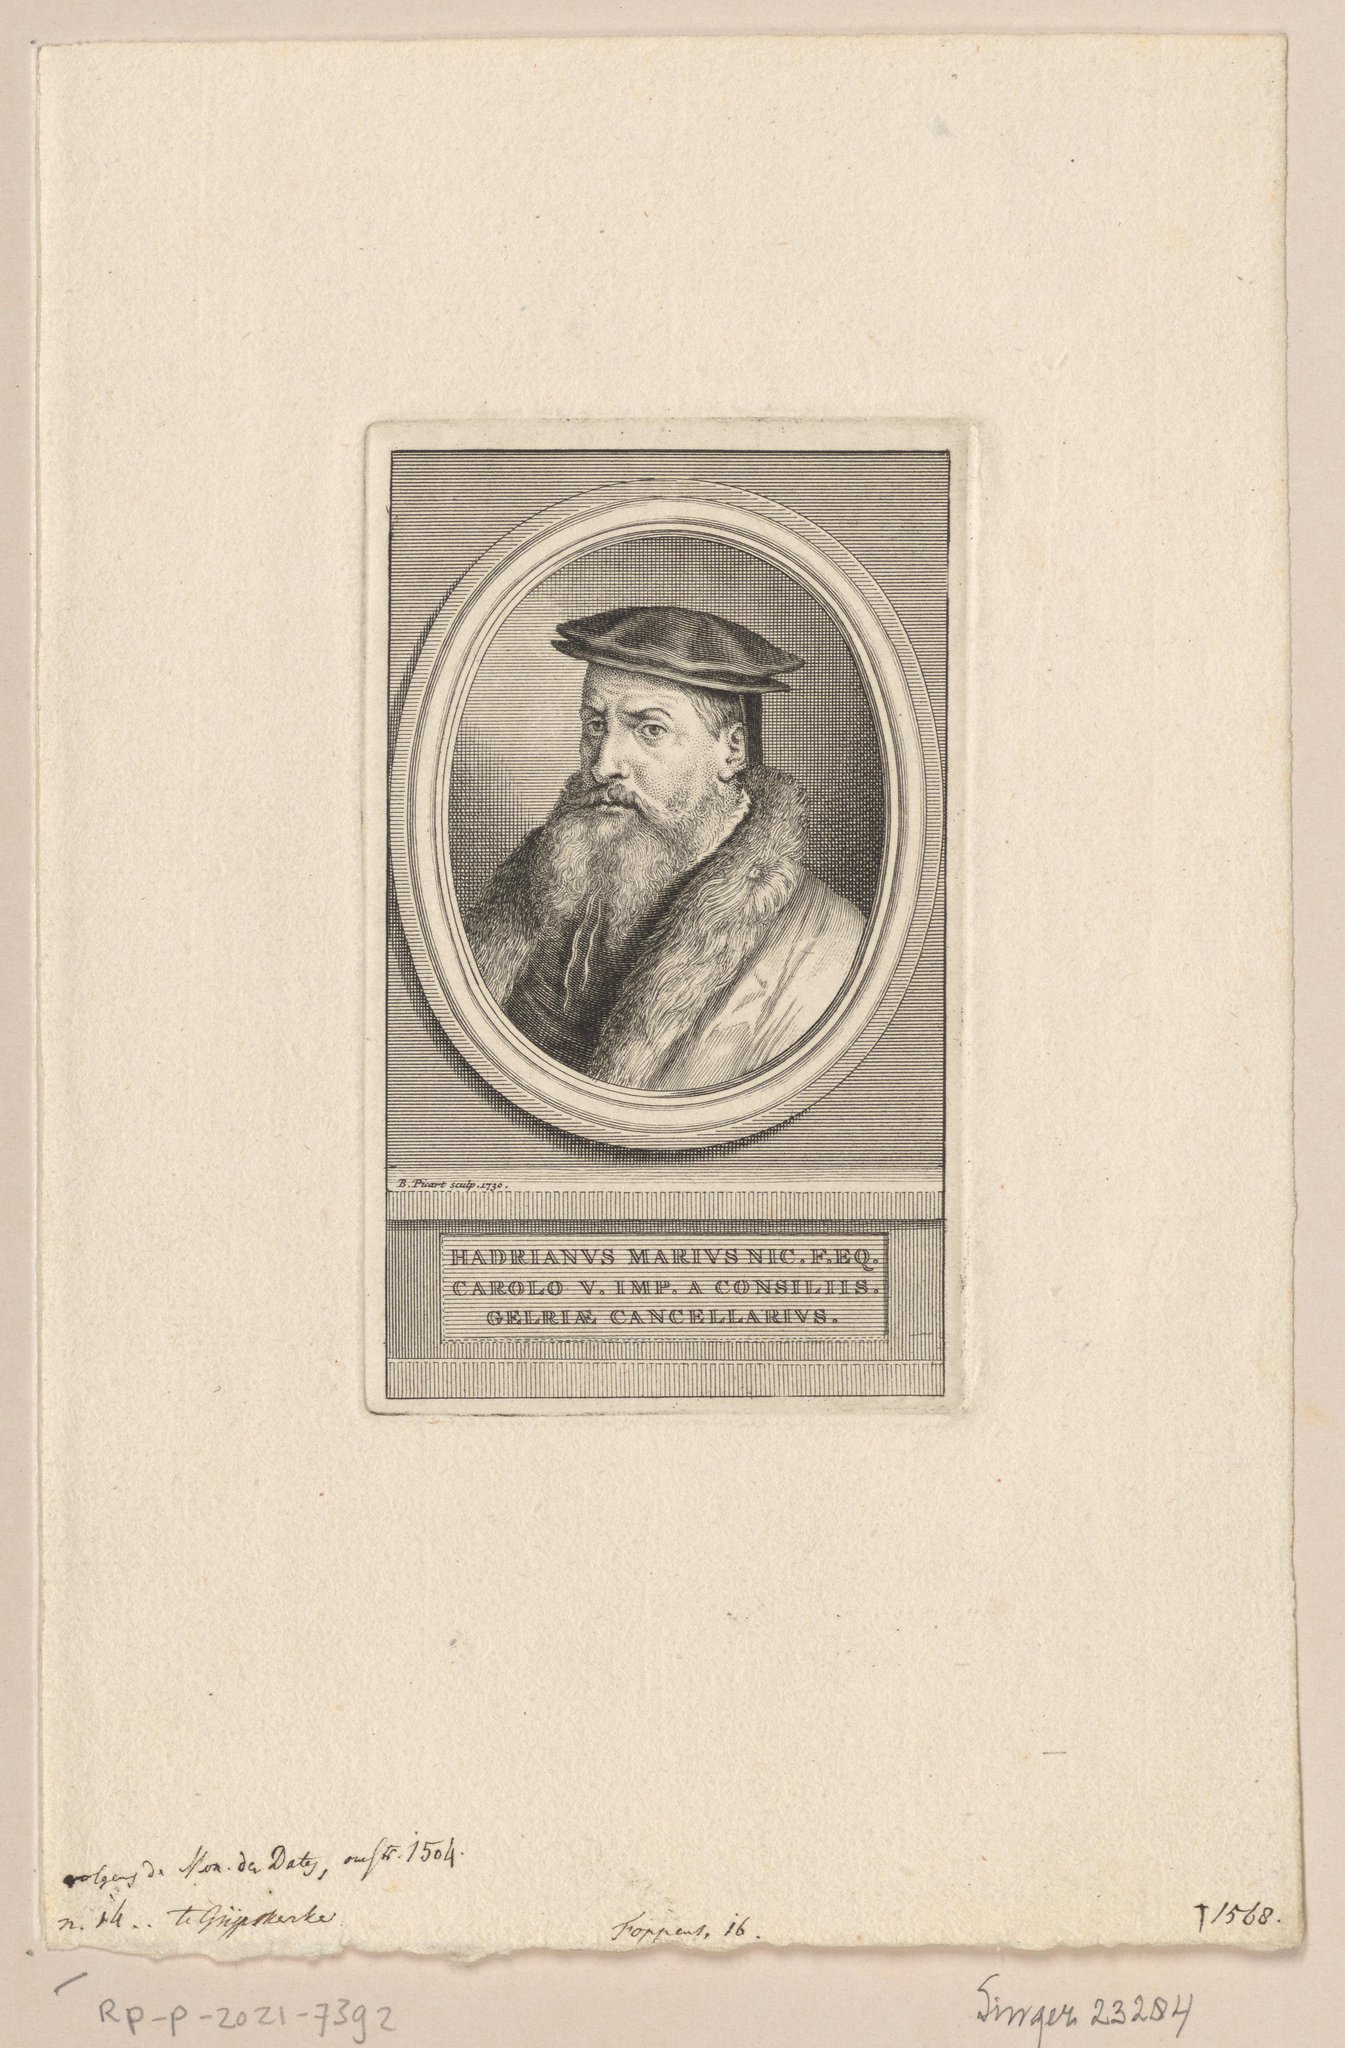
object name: print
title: Portret van Hadrianus Marius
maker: bernard picart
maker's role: draughtsman, print maker, publisher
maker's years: 1673-1733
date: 1730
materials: paper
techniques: etching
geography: amsterdam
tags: mechelen, hadrianus marius, ornament ~ medallion, historical persons, portrait of a writer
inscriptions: date